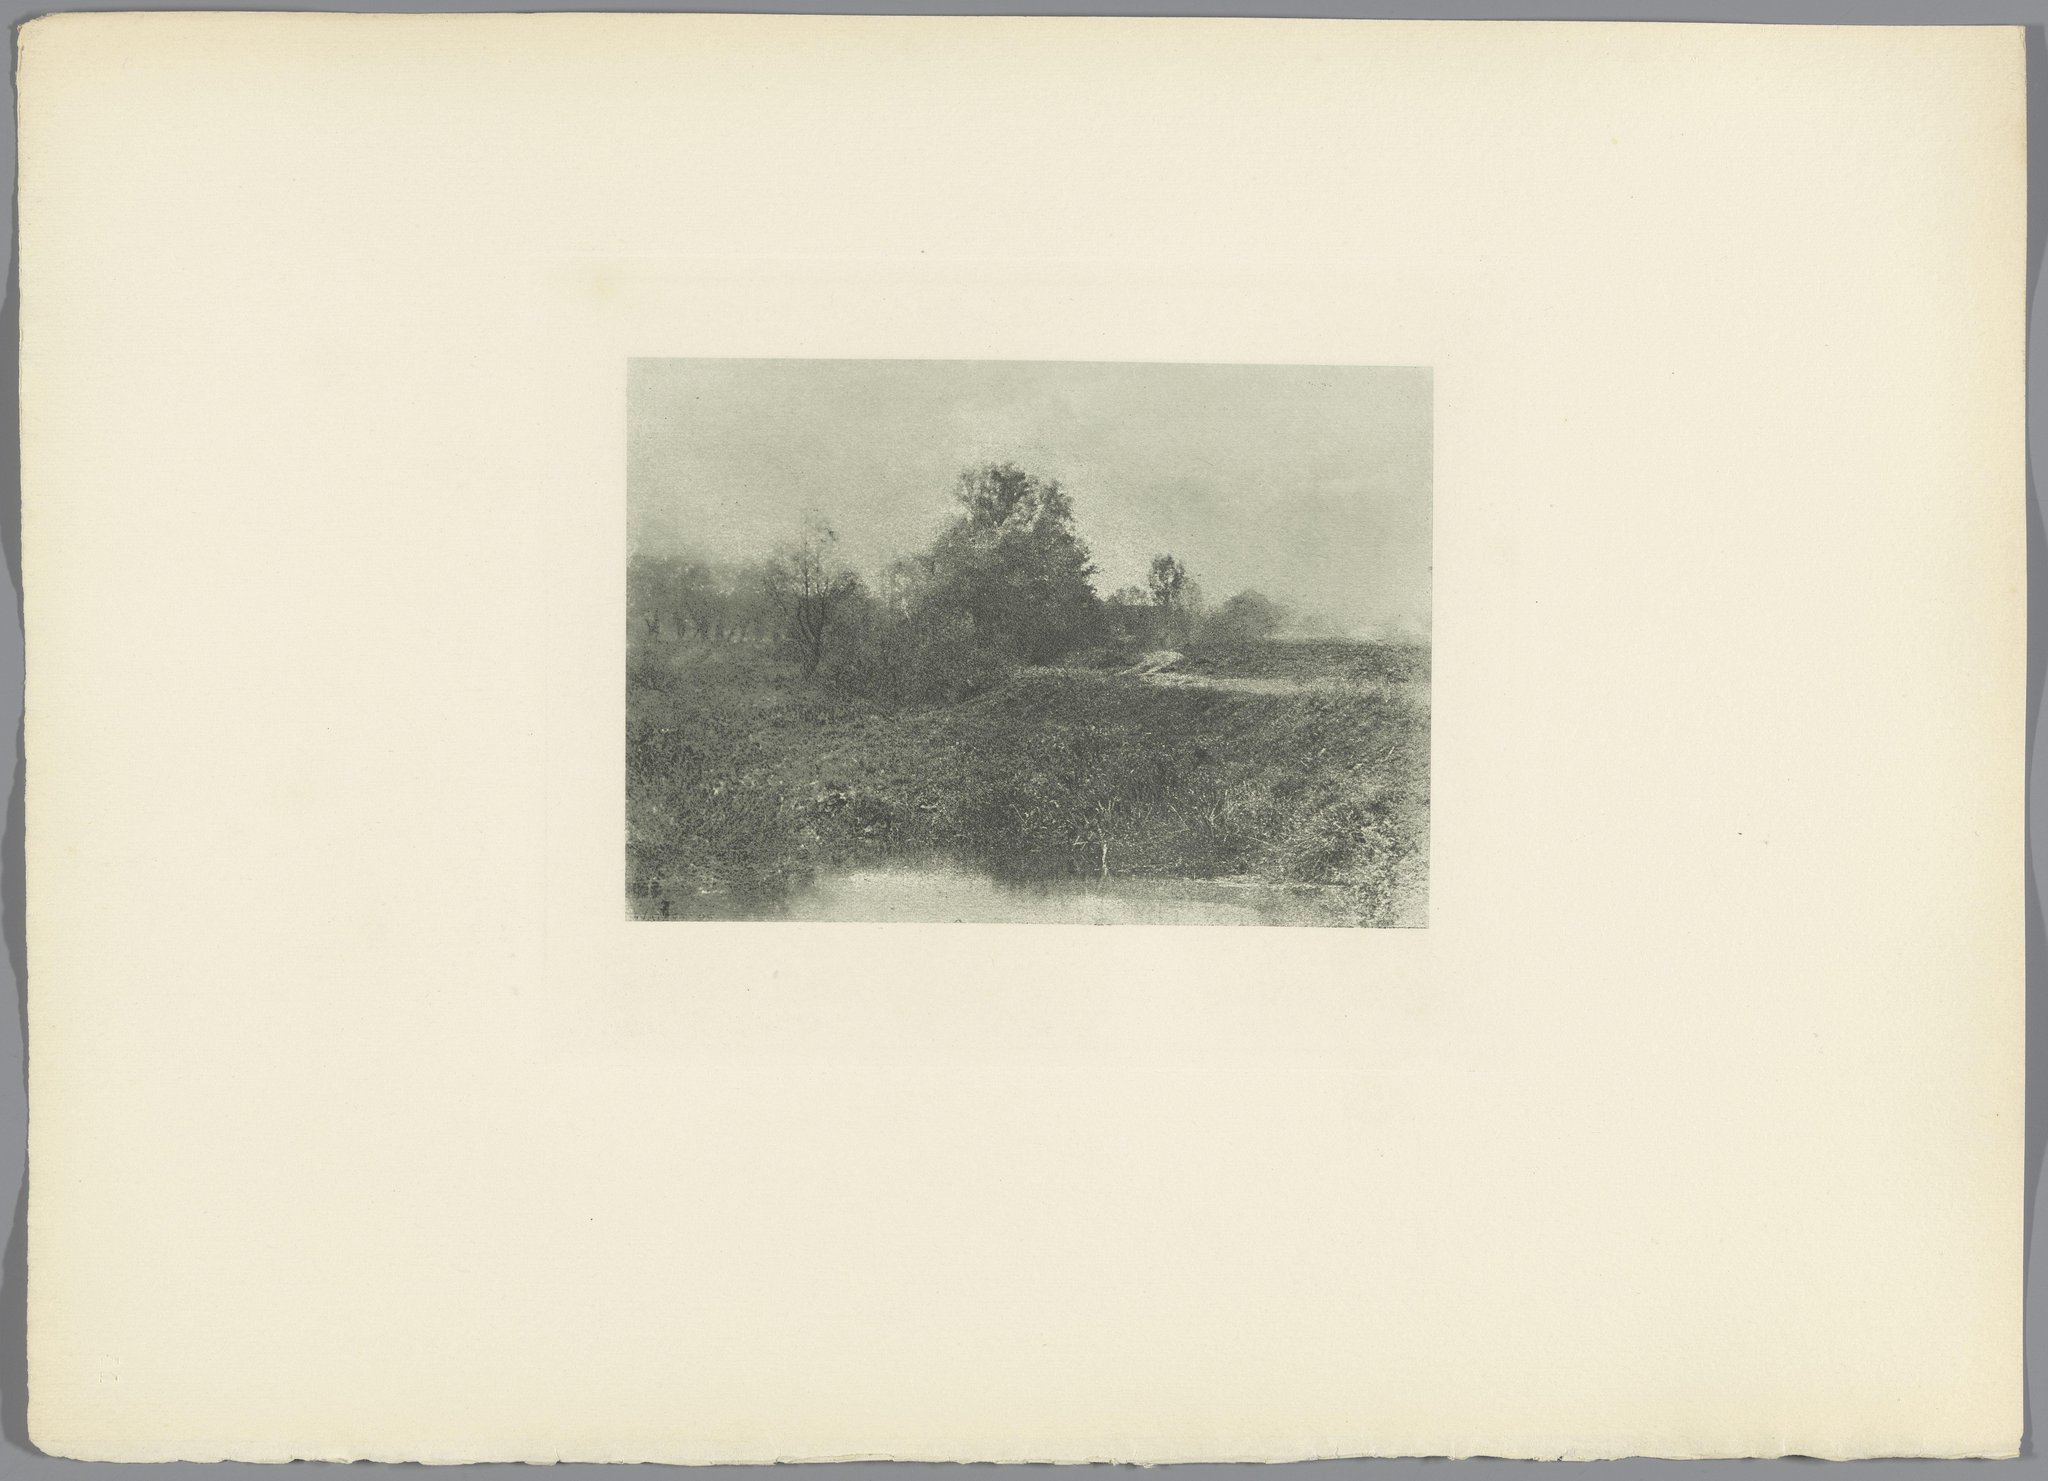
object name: photomechanical print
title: Soir d'automne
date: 1891-1896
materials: paper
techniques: photoaquatint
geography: paris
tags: evening, shrubs, autumn landscape; landscape symbolizing autumn (the four seasons of the year)